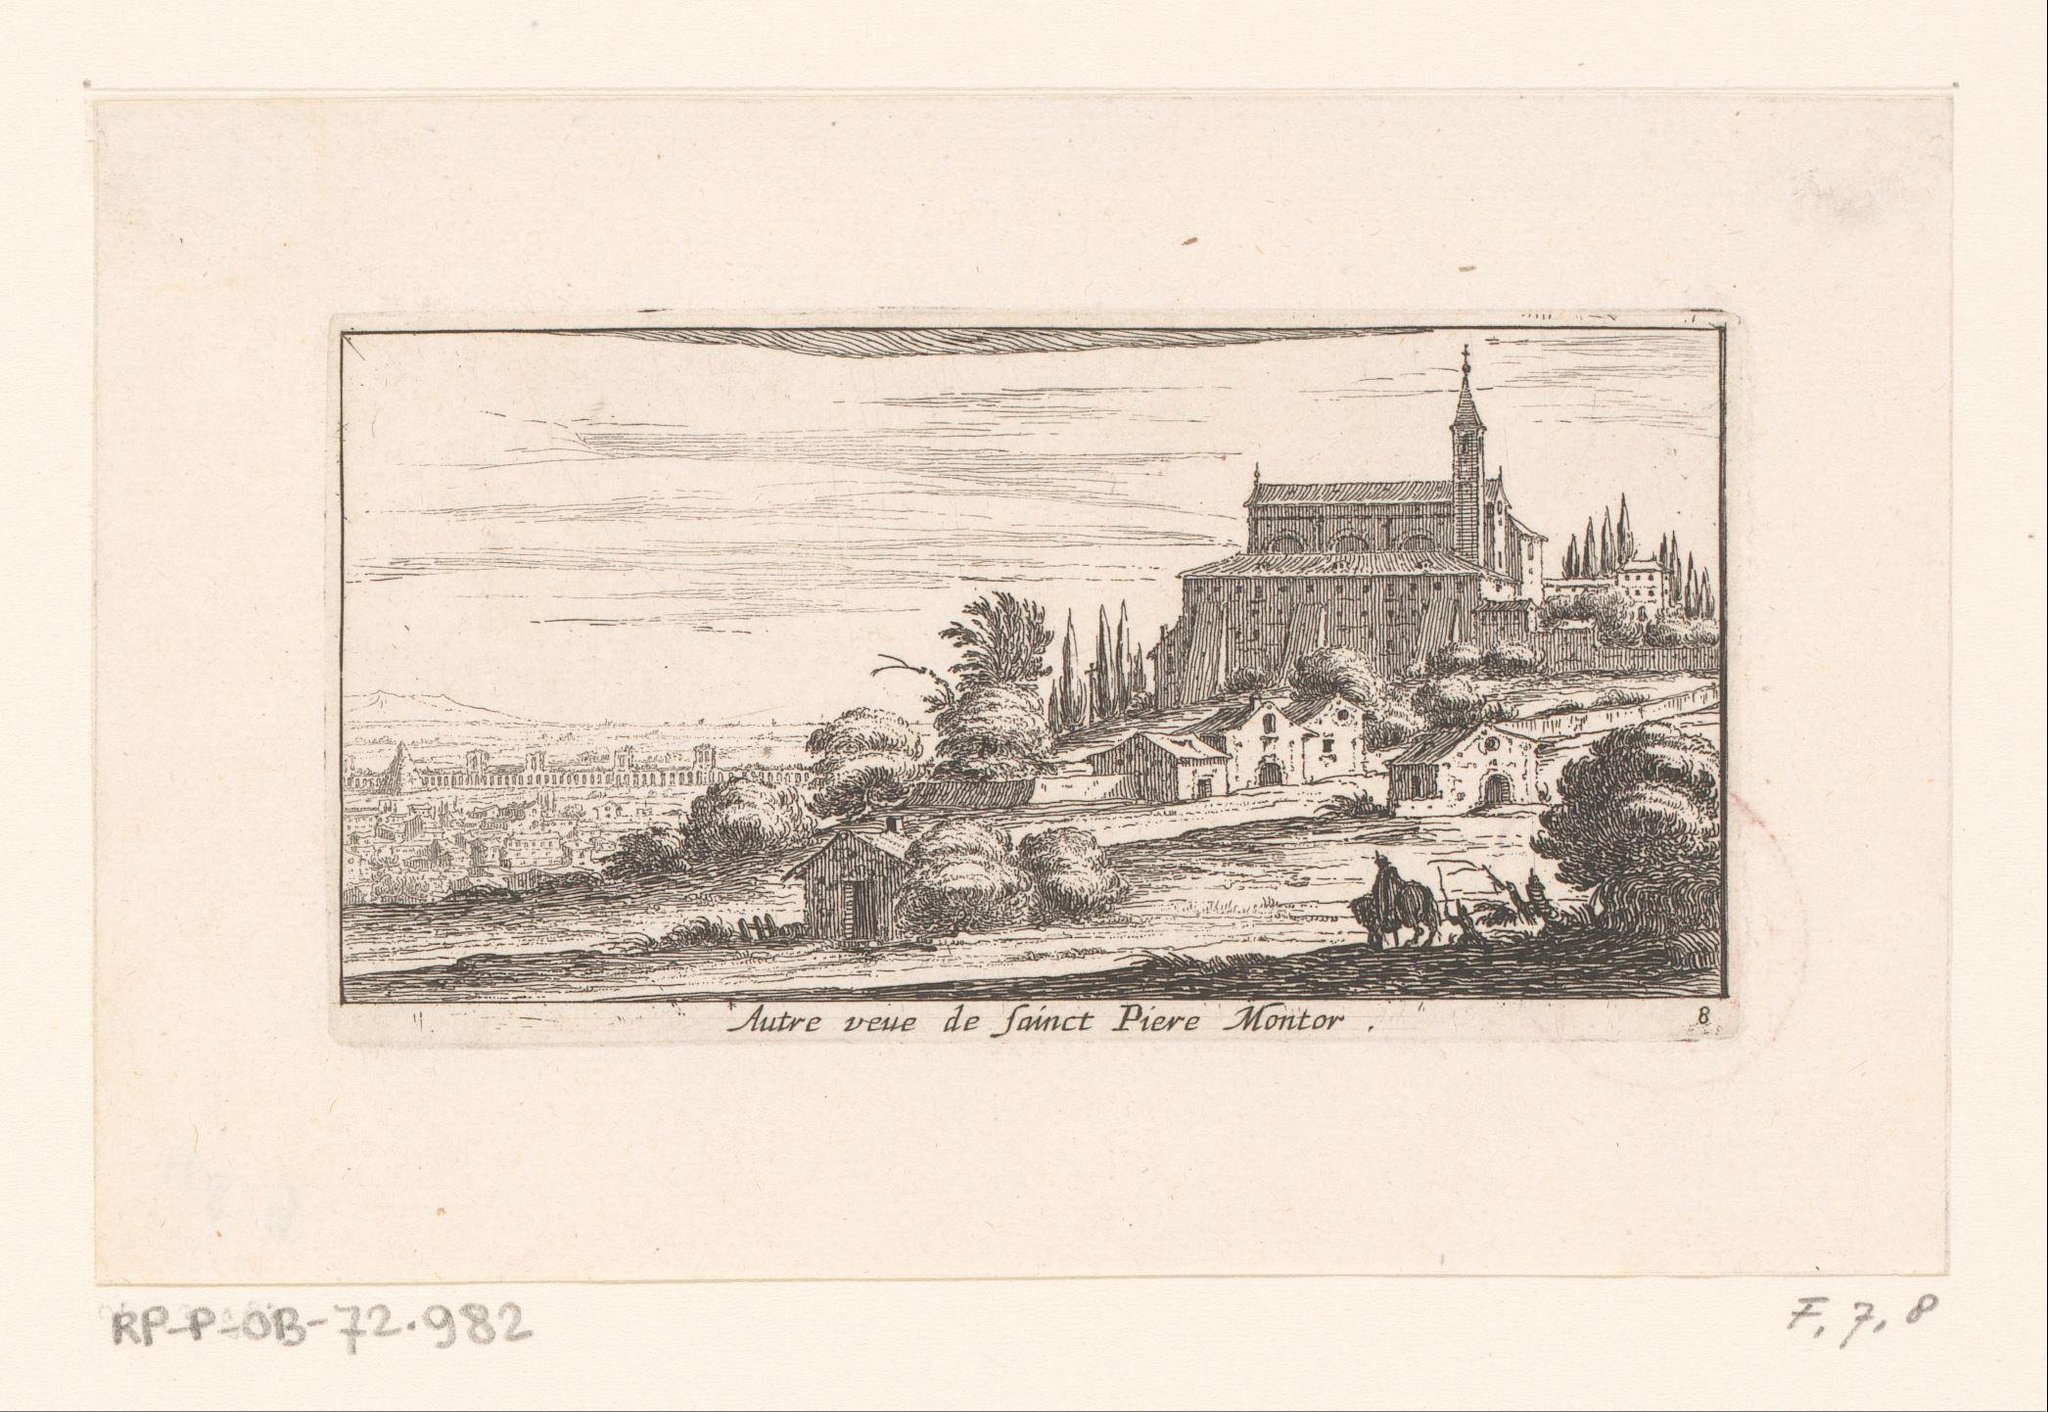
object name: print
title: Autre veue de sainct Piere Montor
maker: israël silvestre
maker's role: draughtsman, print maker, publisher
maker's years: 1621-1691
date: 1636-1661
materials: paper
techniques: etching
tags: city-view in general; 'veduta', church (exterior)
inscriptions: collector's mark: Lugt 240